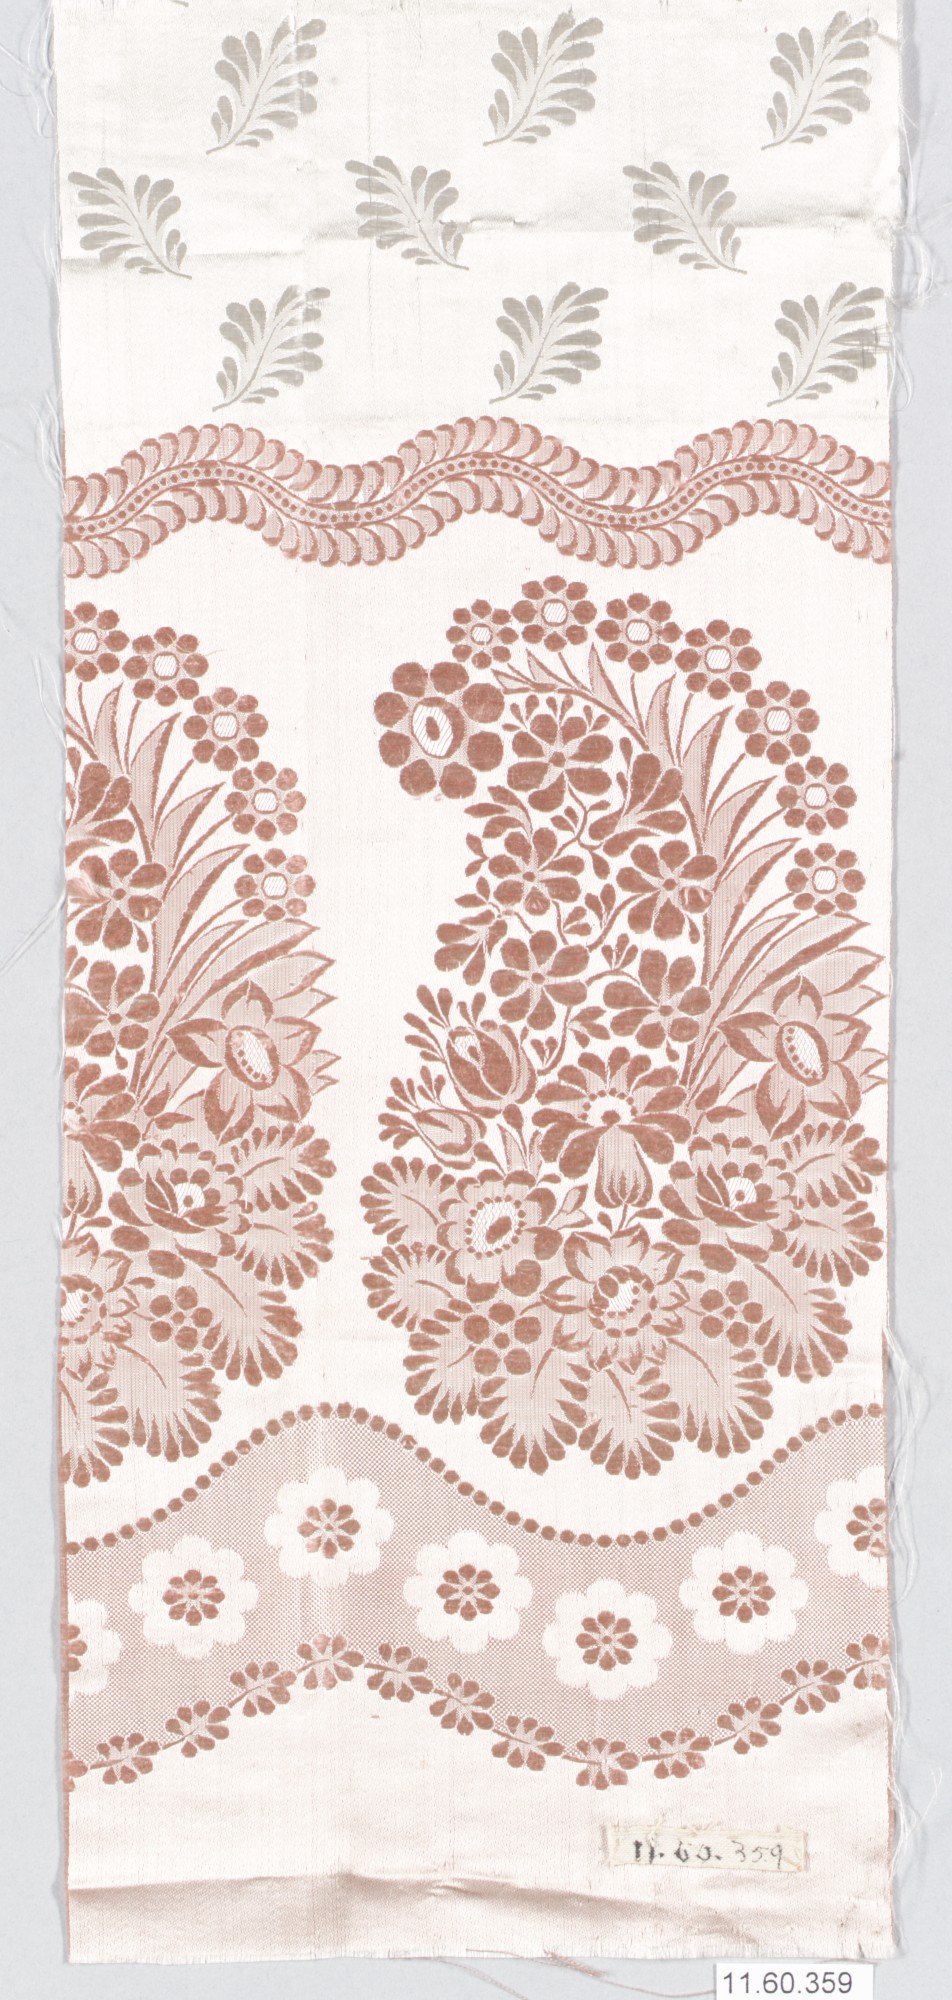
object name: fragment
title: Fragments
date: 1801-1900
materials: silk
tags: flowers,leaves